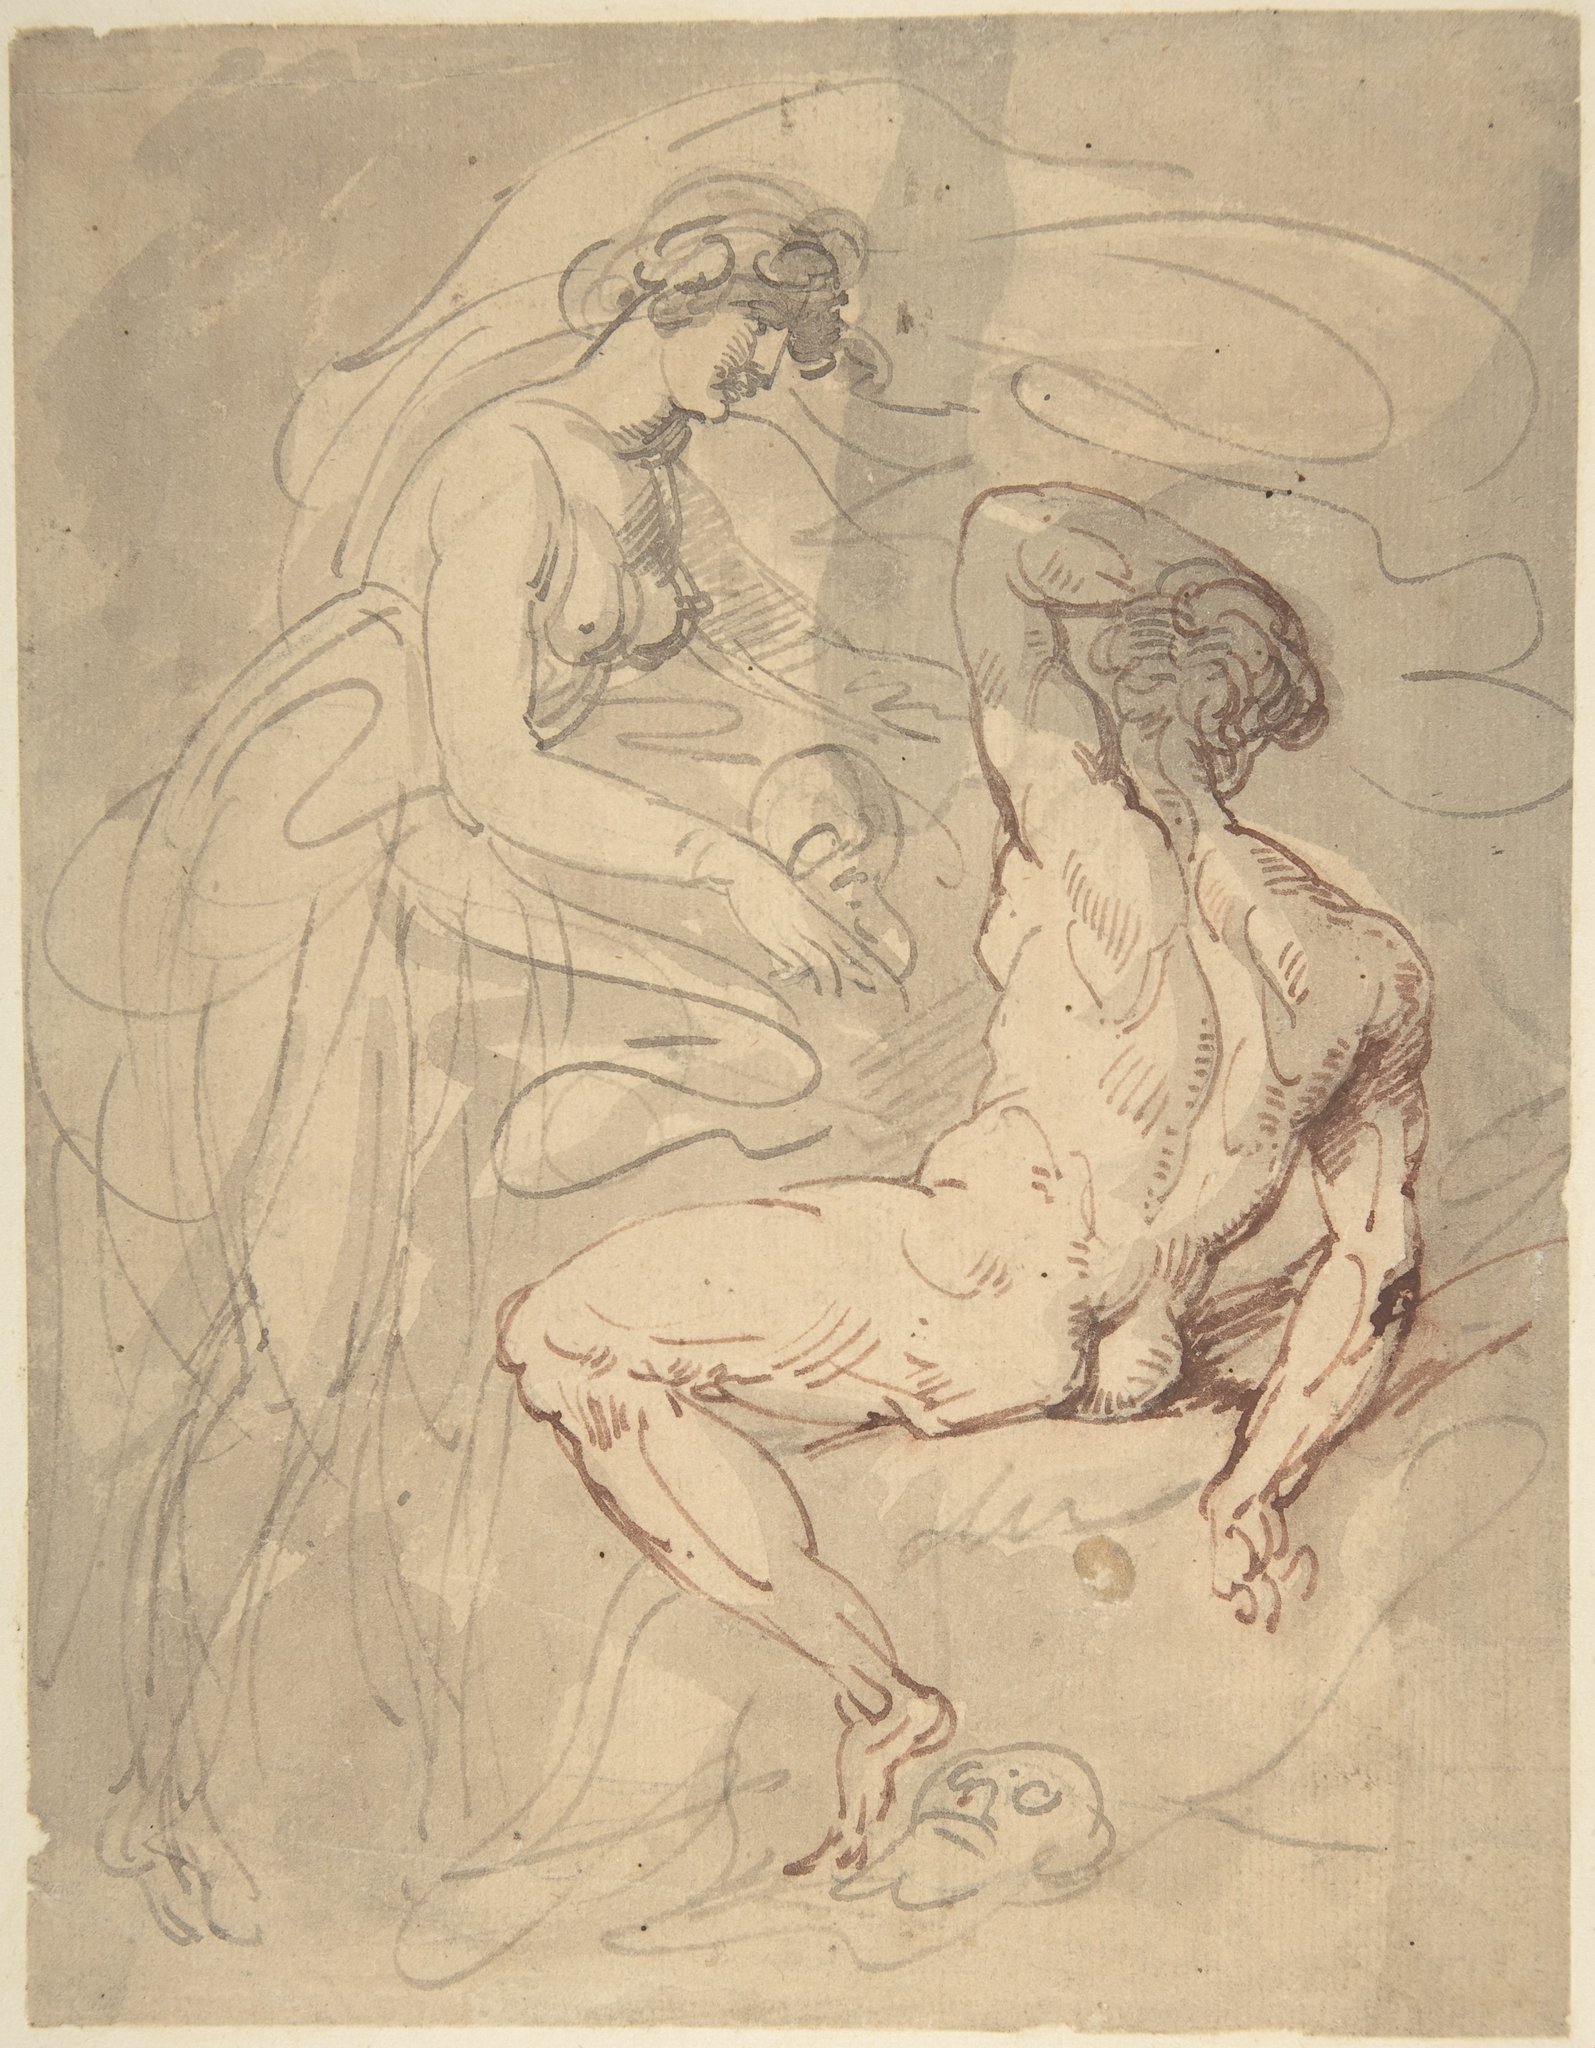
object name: drawing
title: Woman Talking to a Seated Male Nude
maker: thomas rowlandson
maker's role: artist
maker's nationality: british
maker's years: 1757-1827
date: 1775-1827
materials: ink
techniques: brush, pen, wash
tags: male nudes,female nudes